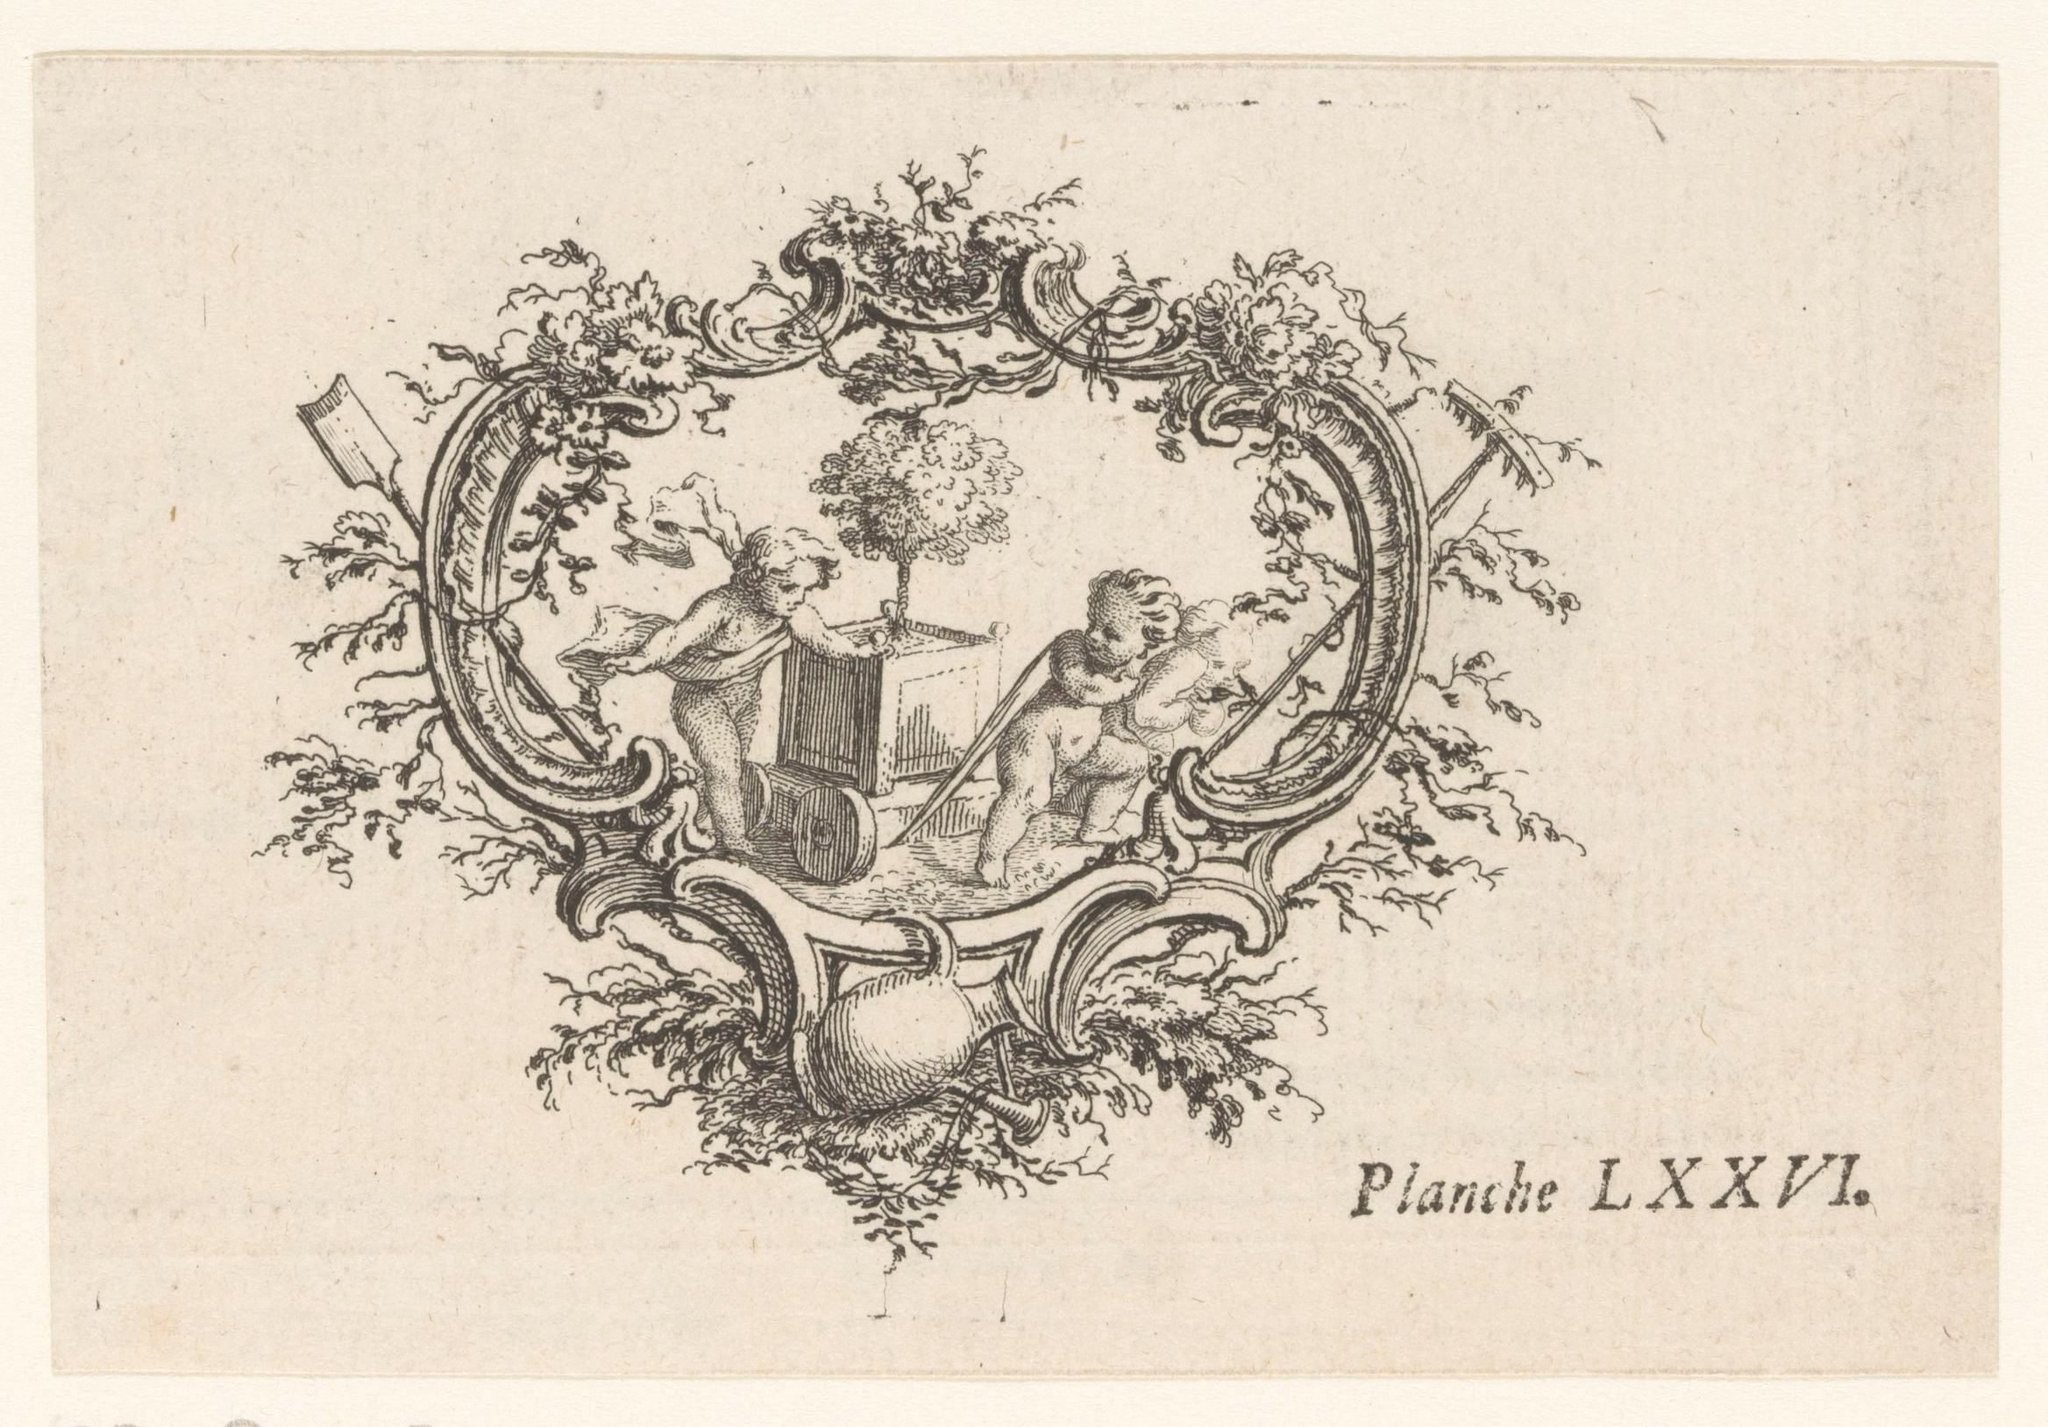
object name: book illustration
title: Vignet met putti in tuin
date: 1750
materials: paper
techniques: etching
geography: paris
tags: garden, cupids: 'amores', 'amoretti', 'putti'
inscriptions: collector's mark: Lugt 2228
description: Vignet met drie putti in een tuin in rocaille cartouche met tuingereedschap. Twee putti trekken aan een kar waarop een boom staat. Planche LXXVI.